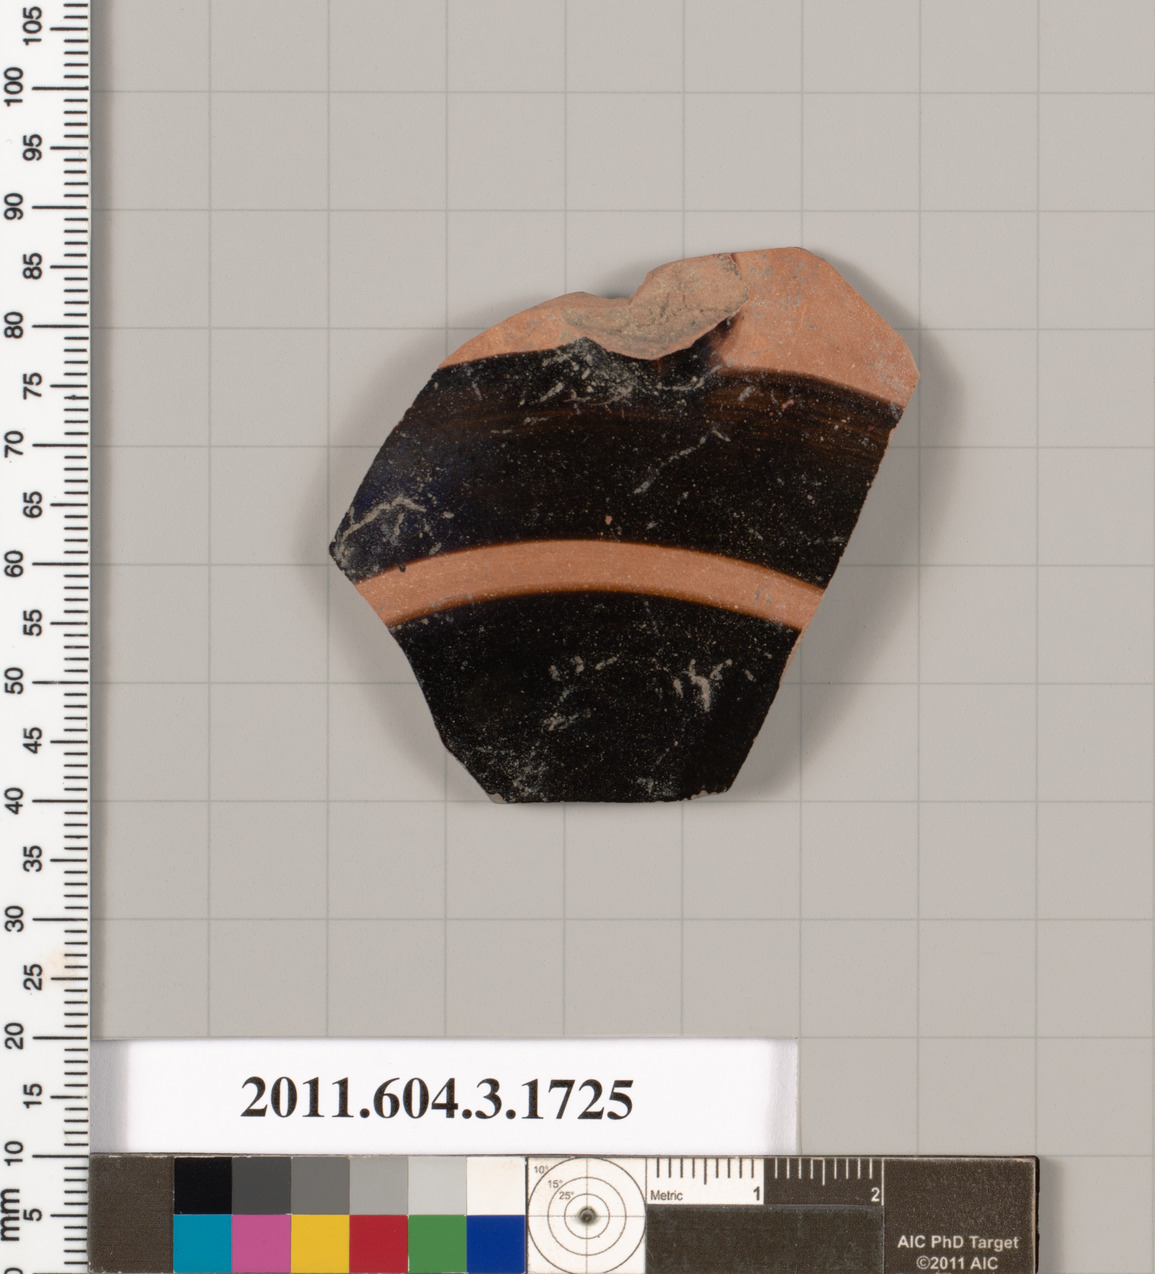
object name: kylix fragment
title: Terracotta fragment of a kylix: Band or lip cup (drinking cup)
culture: greek, attic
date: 550-526 BCE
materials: terracotta